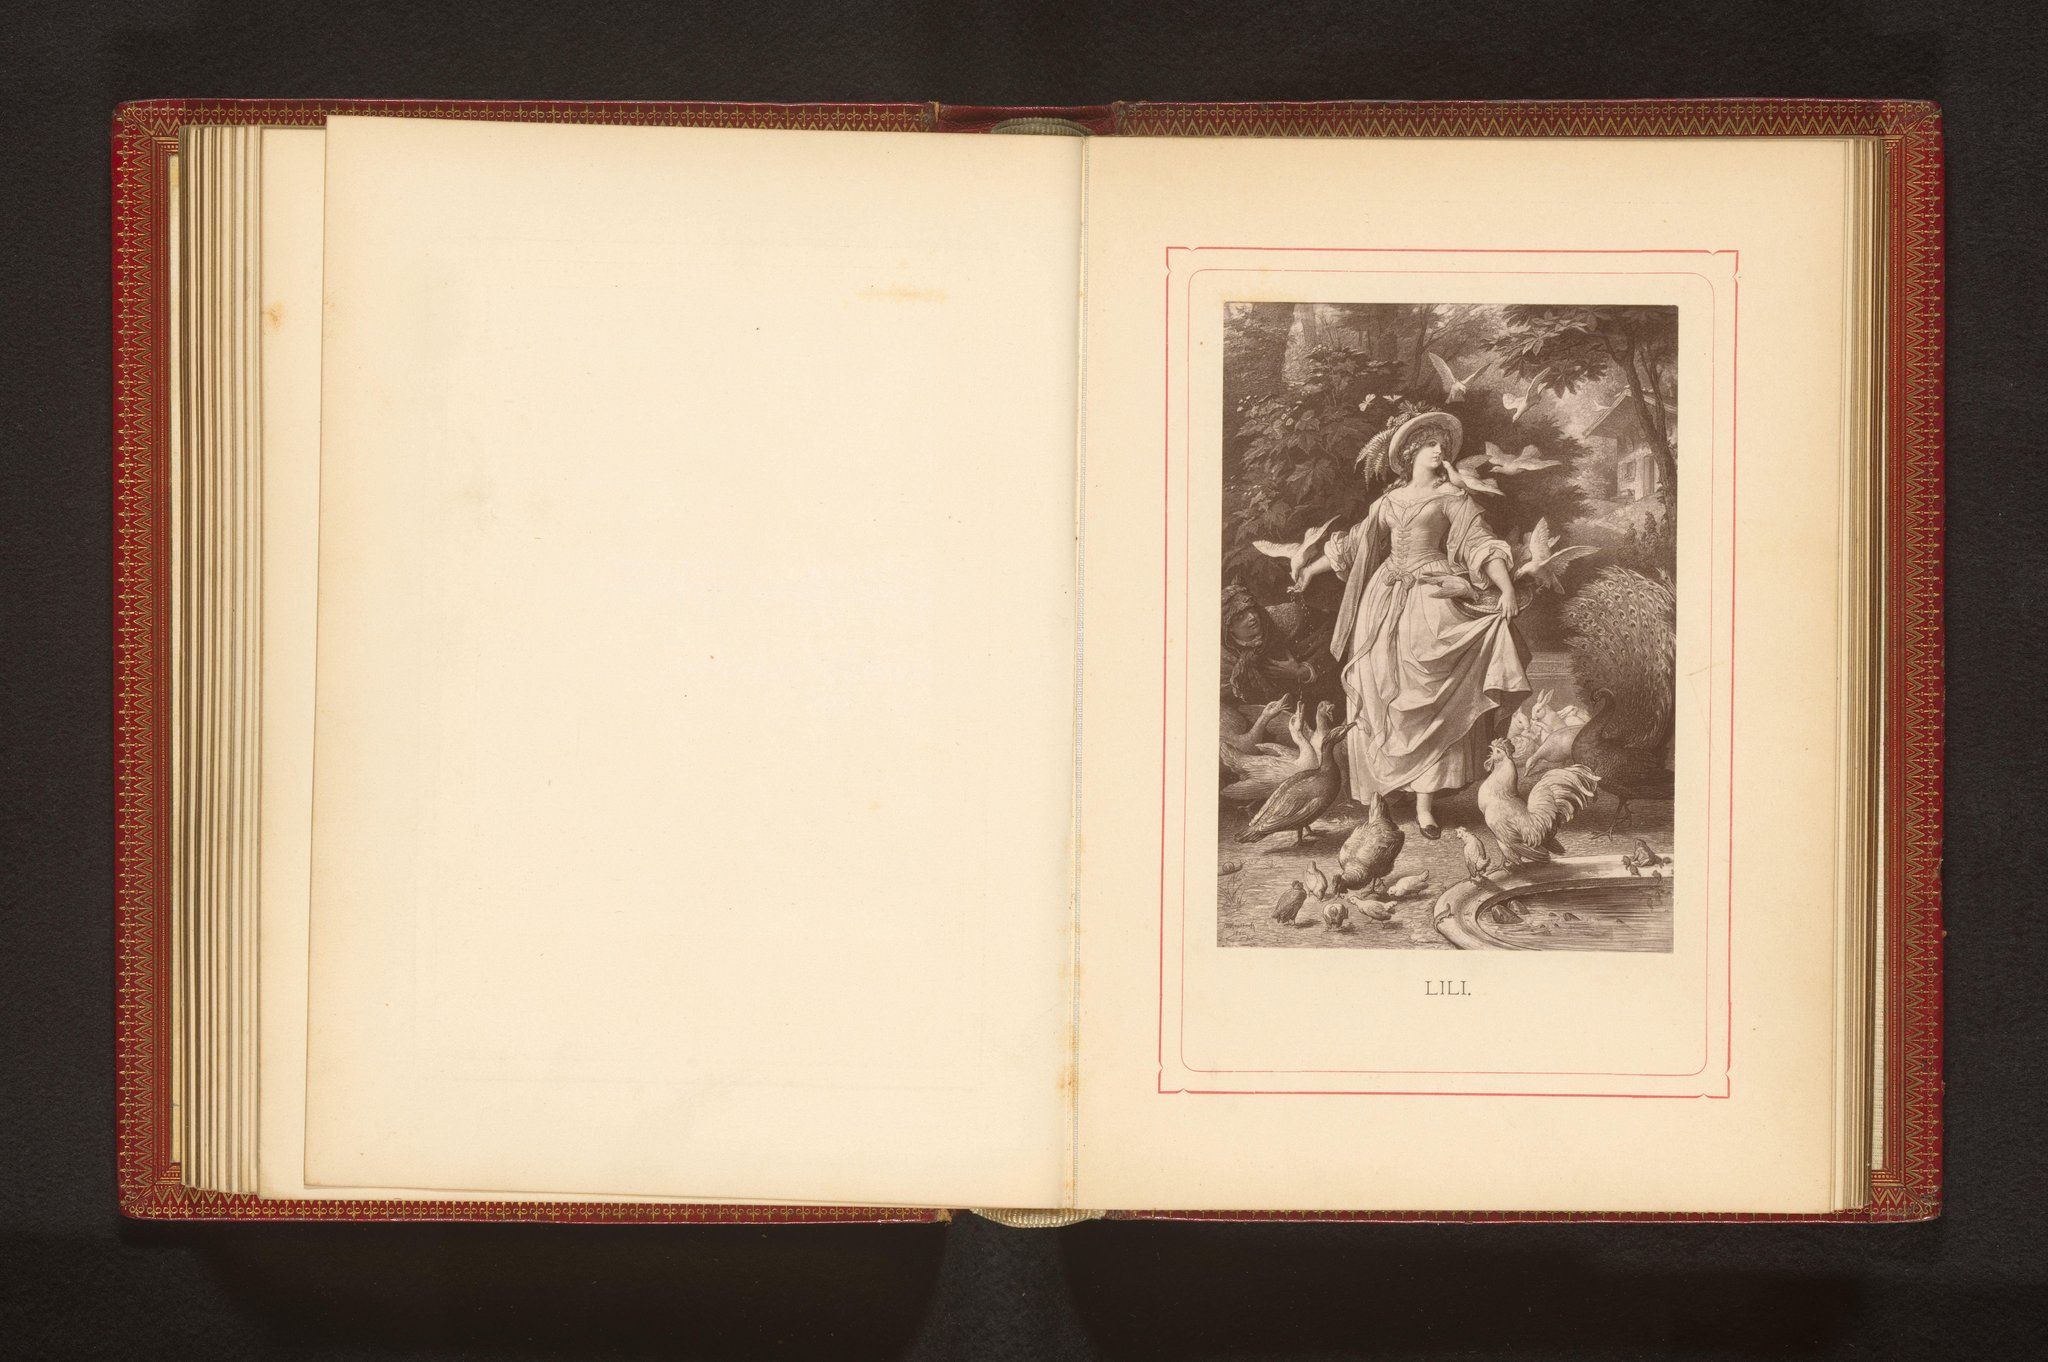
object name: page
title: Lili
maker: Anonymous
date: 1875-1885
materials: paper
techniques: photograph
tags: adult woman, birds, public gardens, park